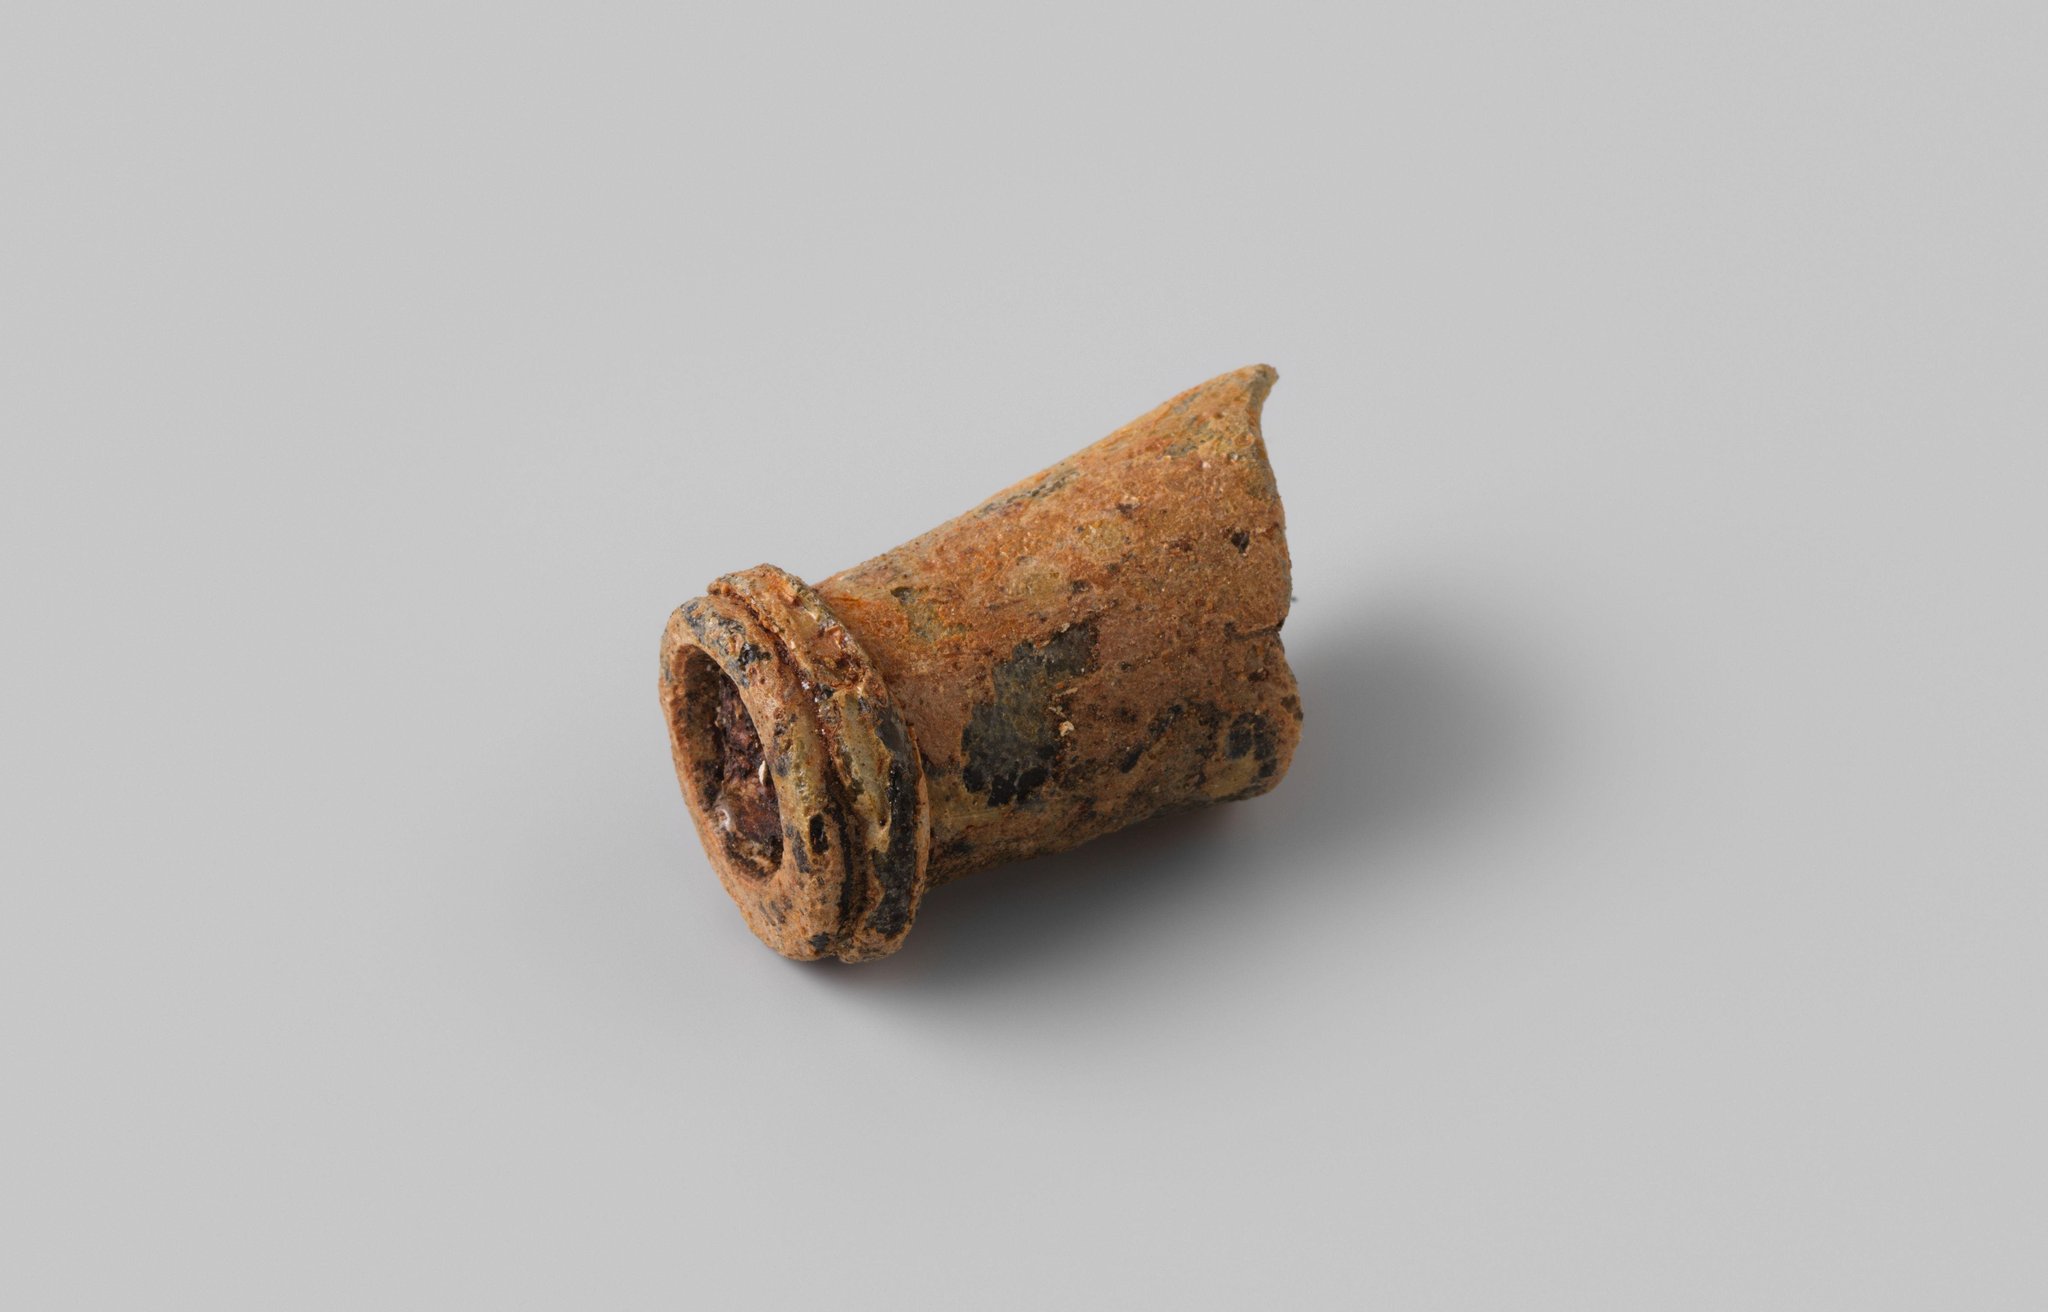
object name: wine bottle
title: Hals met kurk van een wijnfles uit het wrak van de Oost-Indiëvaarder Hollandia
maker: Anonymous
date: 1700-1743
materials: cork, glass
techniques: green glass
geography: netherlands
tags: verenigde oostindische compagnie, hollandia (schip), annet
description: Wine bottle, continental production, neck, onion-shaped bottle or bottle with vertical side; fragm, f-string rim, projecting cork